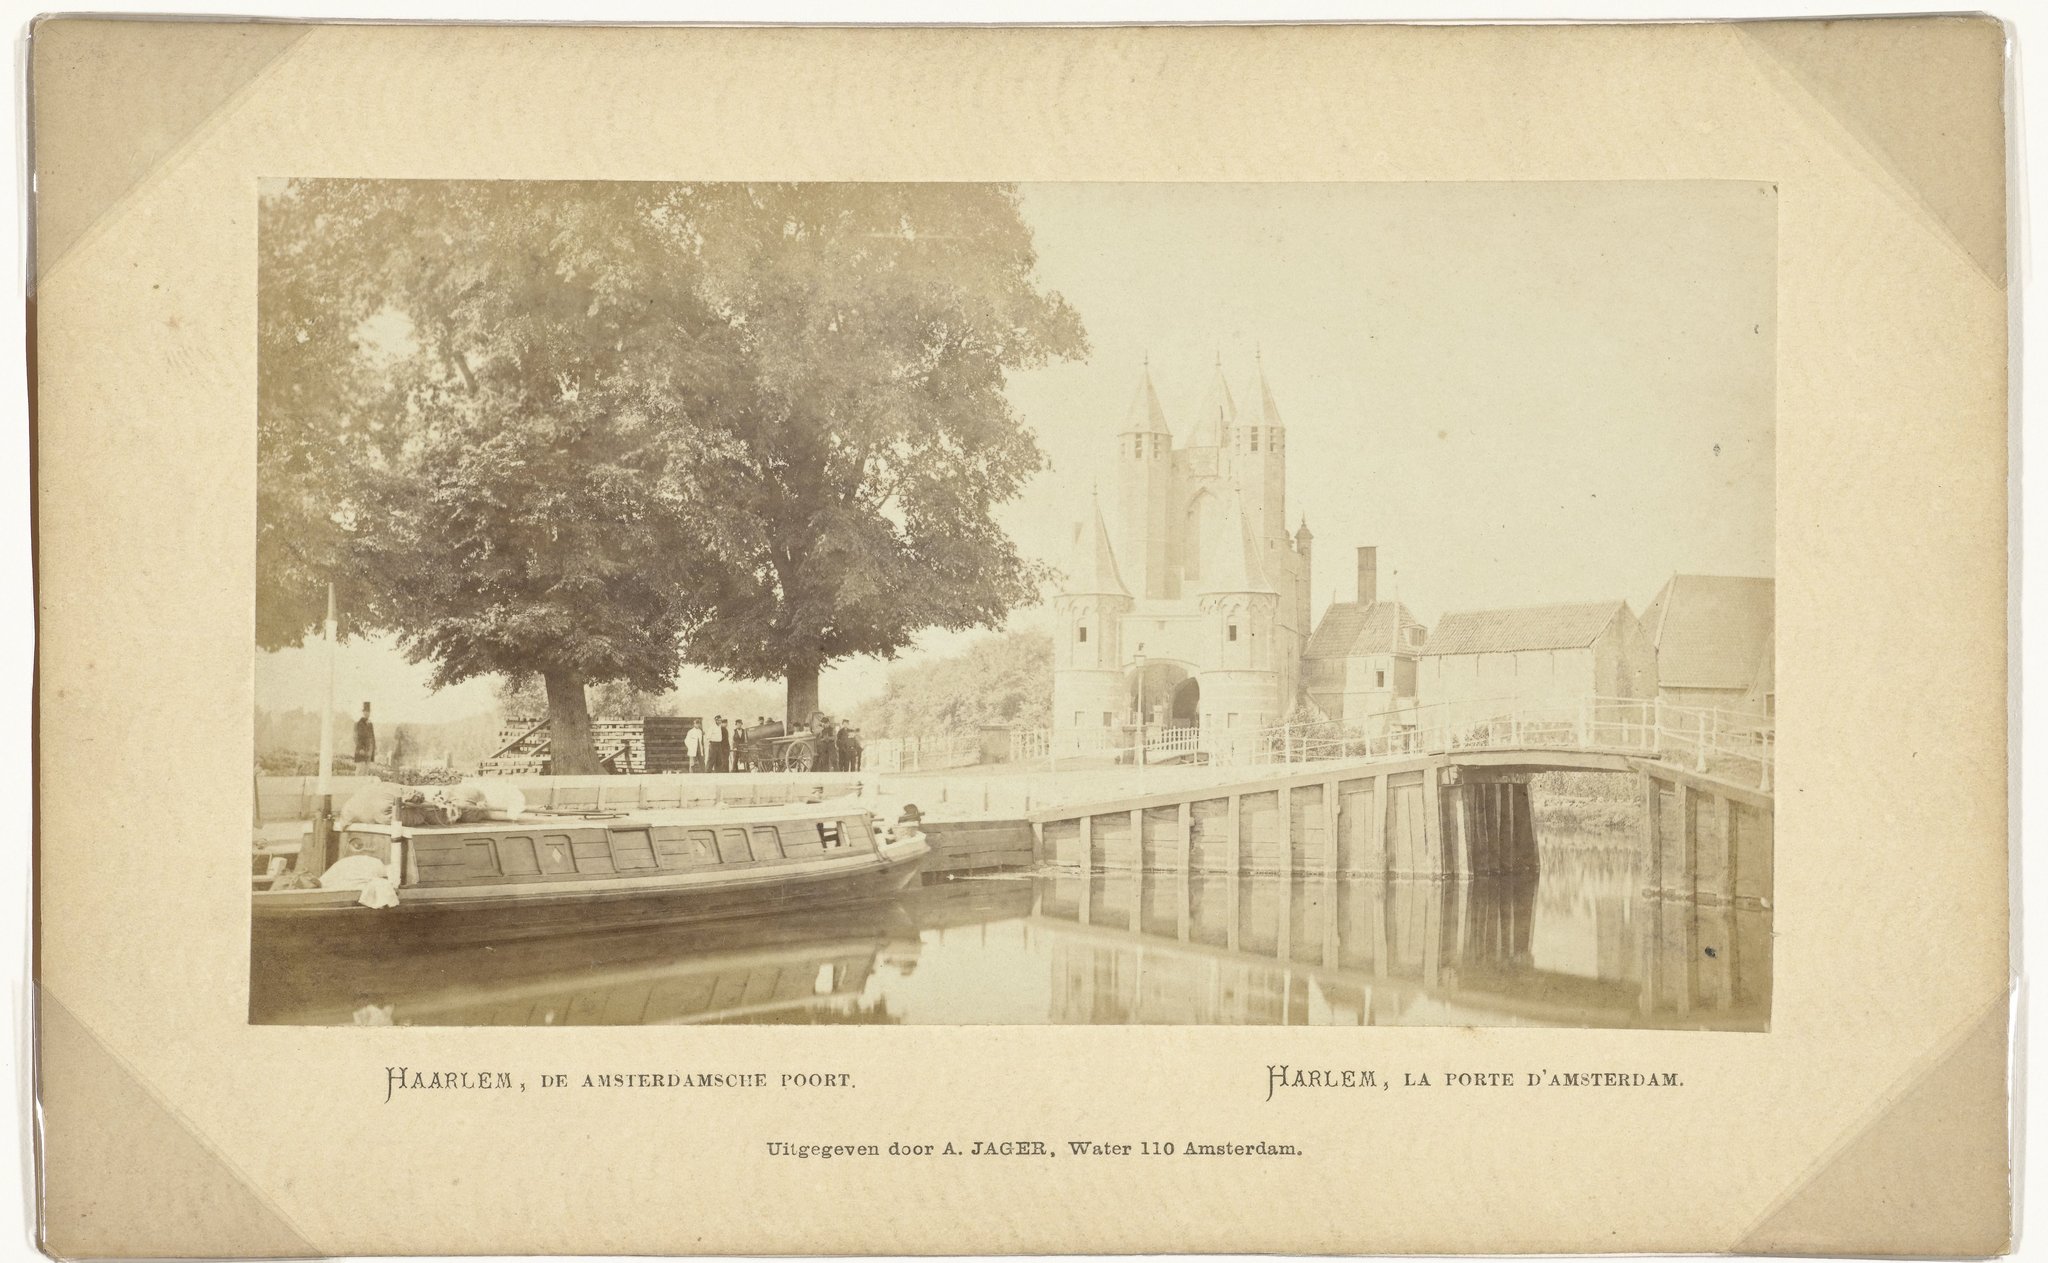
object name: photograph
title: Gezicht op de Amsterdamse Poort in Haarlem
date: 1870-1890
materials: paper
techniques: albumen print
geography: netherlands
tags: canals, waters (in city), city-gate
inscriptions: annotation: ‘Haarlem, de Amsterdamsche Poort/ Harlem, la porte d'Amsterdam’, signature: ‘uitgegeven door A. Jager. Water 110 Amsterdam’